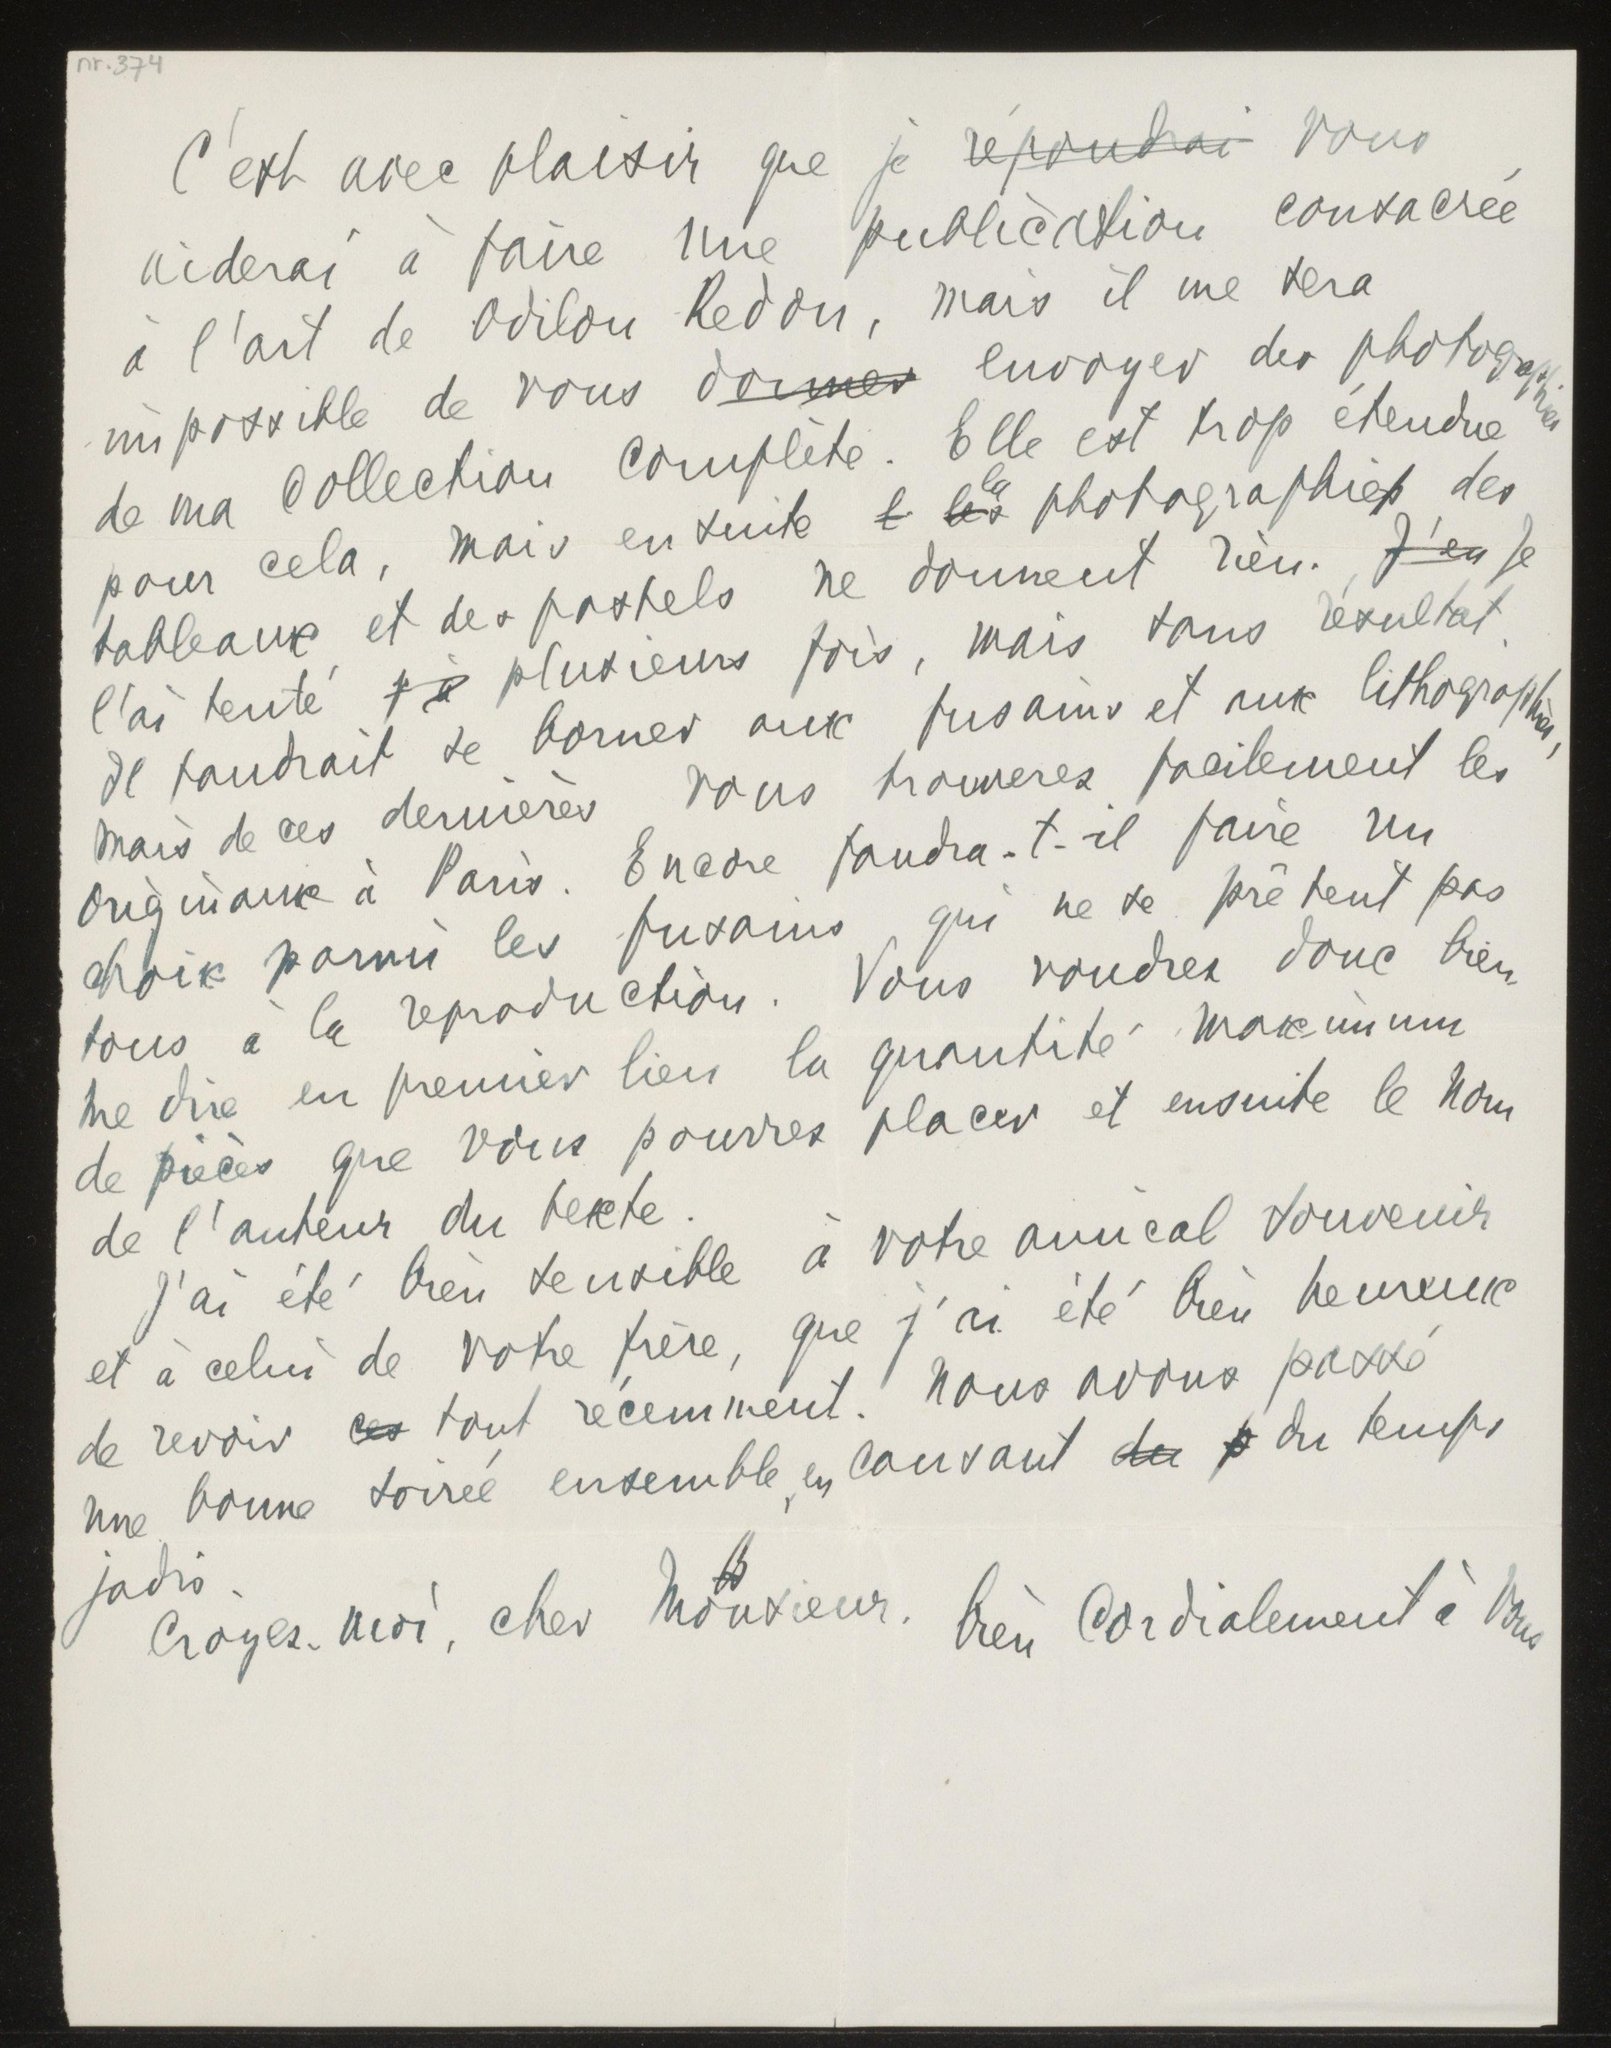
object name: letter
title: Conceptbrief aan anoniem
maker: andries bonger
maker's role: kunstverzamelaar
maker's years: 1861-1936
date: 1871-1936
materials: ink, paper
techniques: pen, writing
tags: paris, painter, print maker, draughtsman, odilon redon, the graphic arts, printed matter